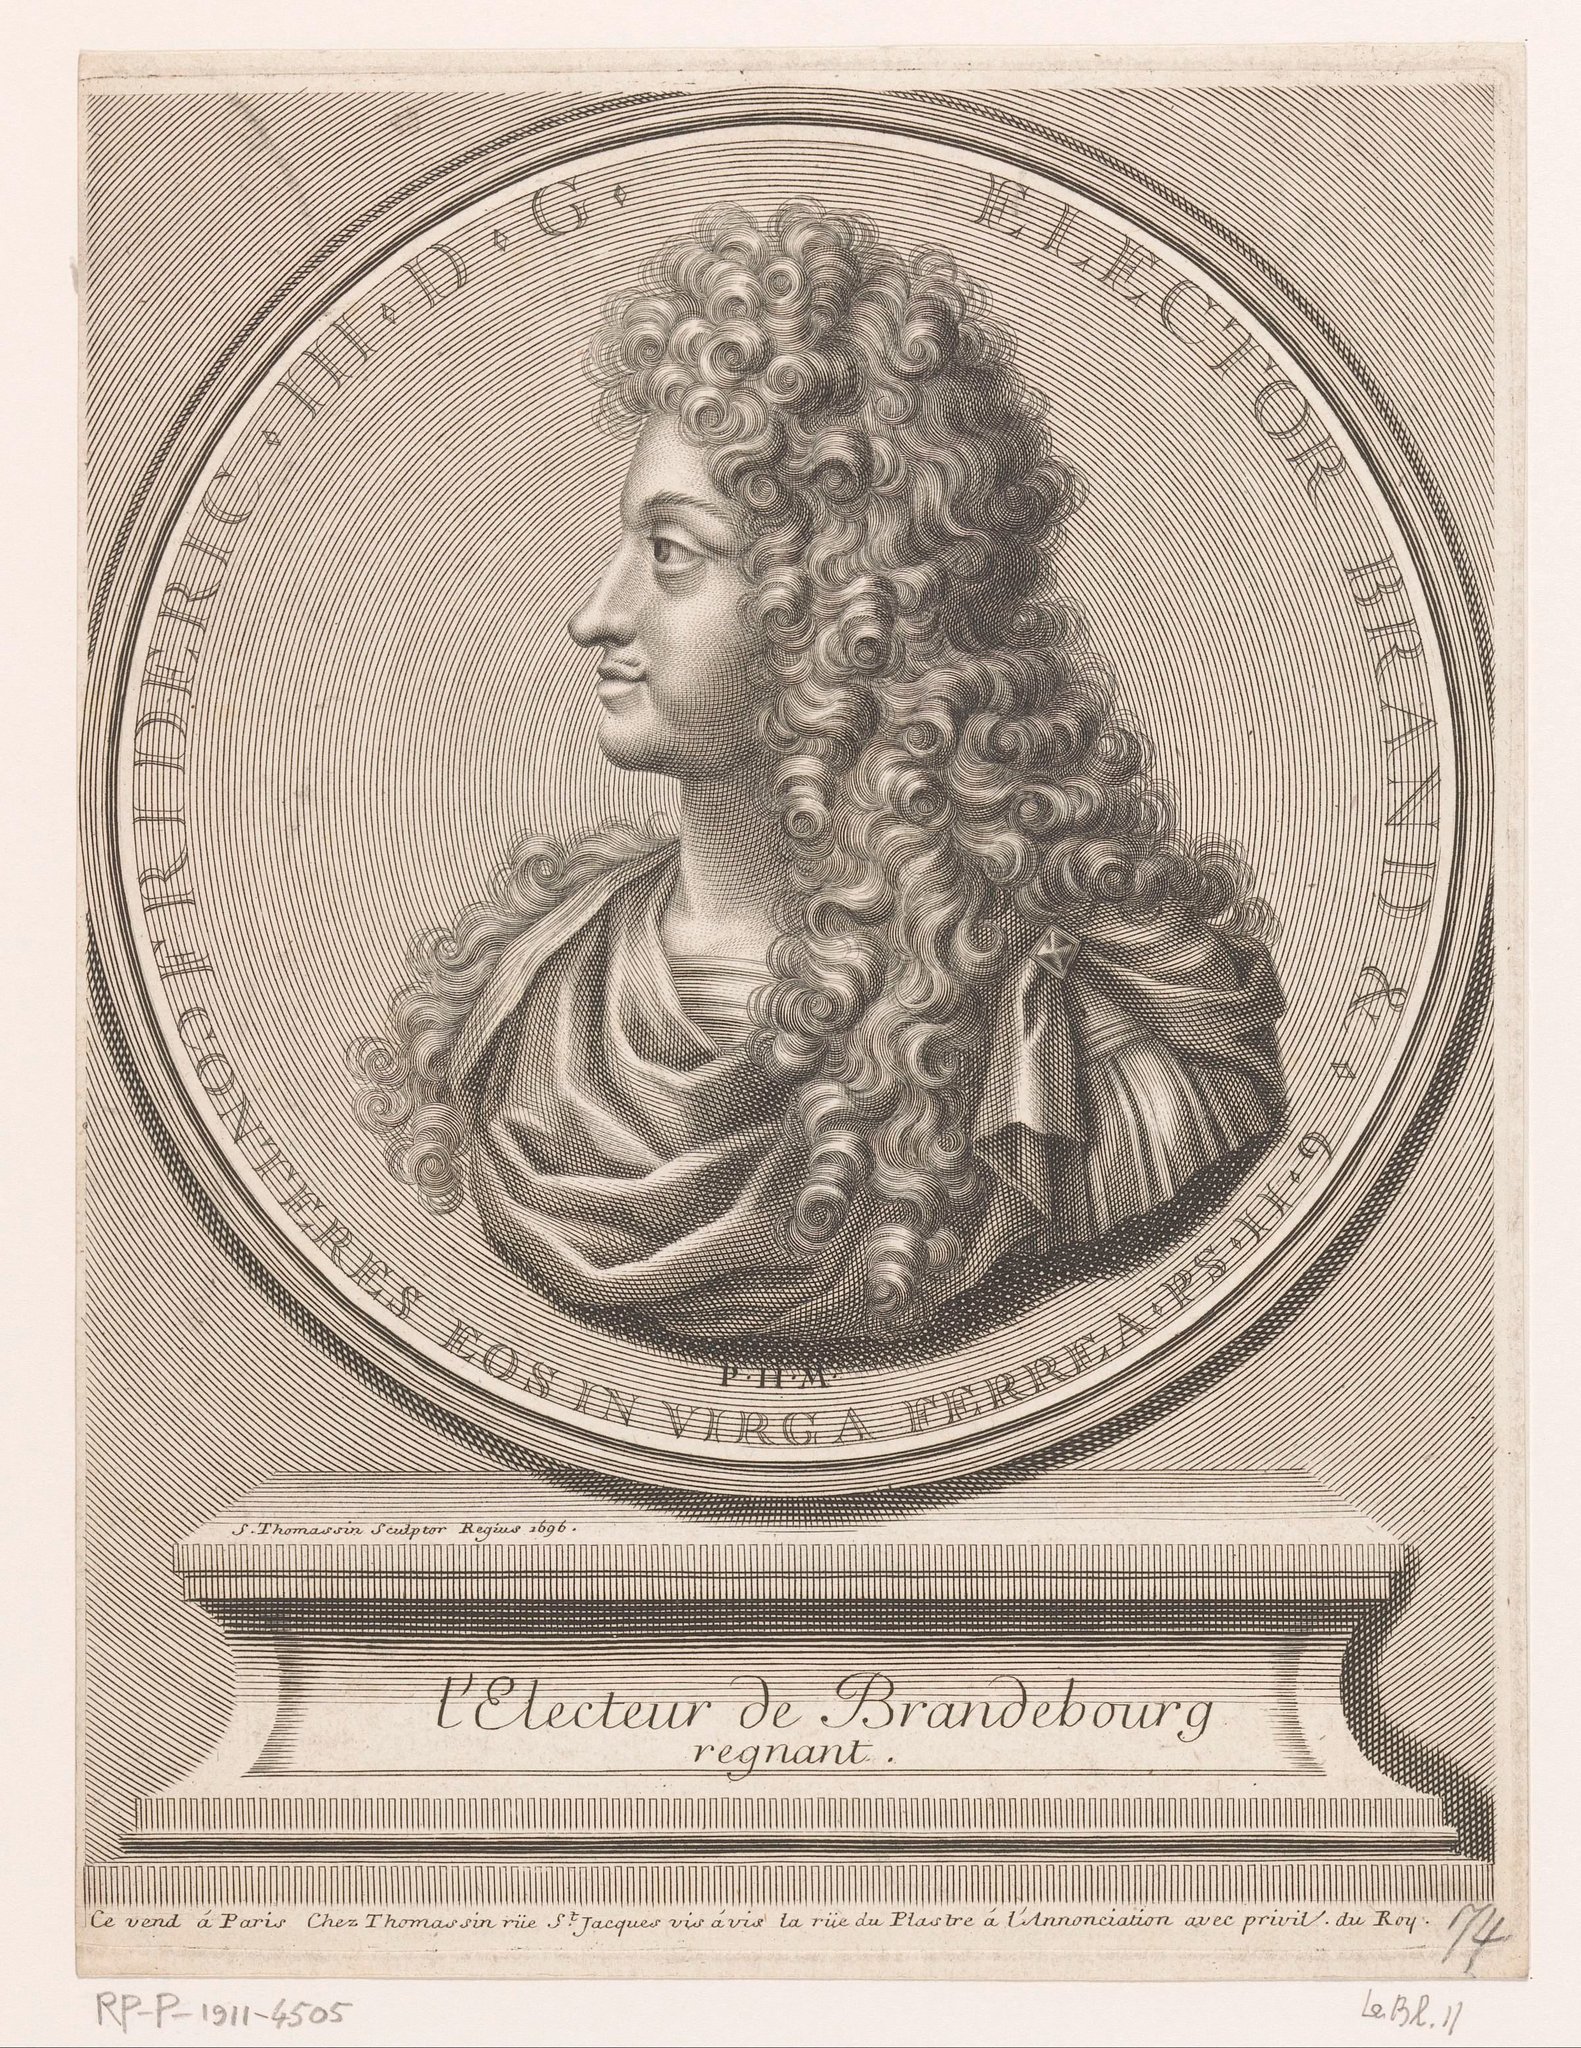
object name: print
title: Frideric III D.G. Elector Brand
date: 1696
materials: paper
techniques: engraving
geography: france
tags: frederik i koning van pruisen, historical persons, medal (considered as a piece of sculpture, regardless of its specific function), king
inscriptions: collector's mark: Lugt 2228